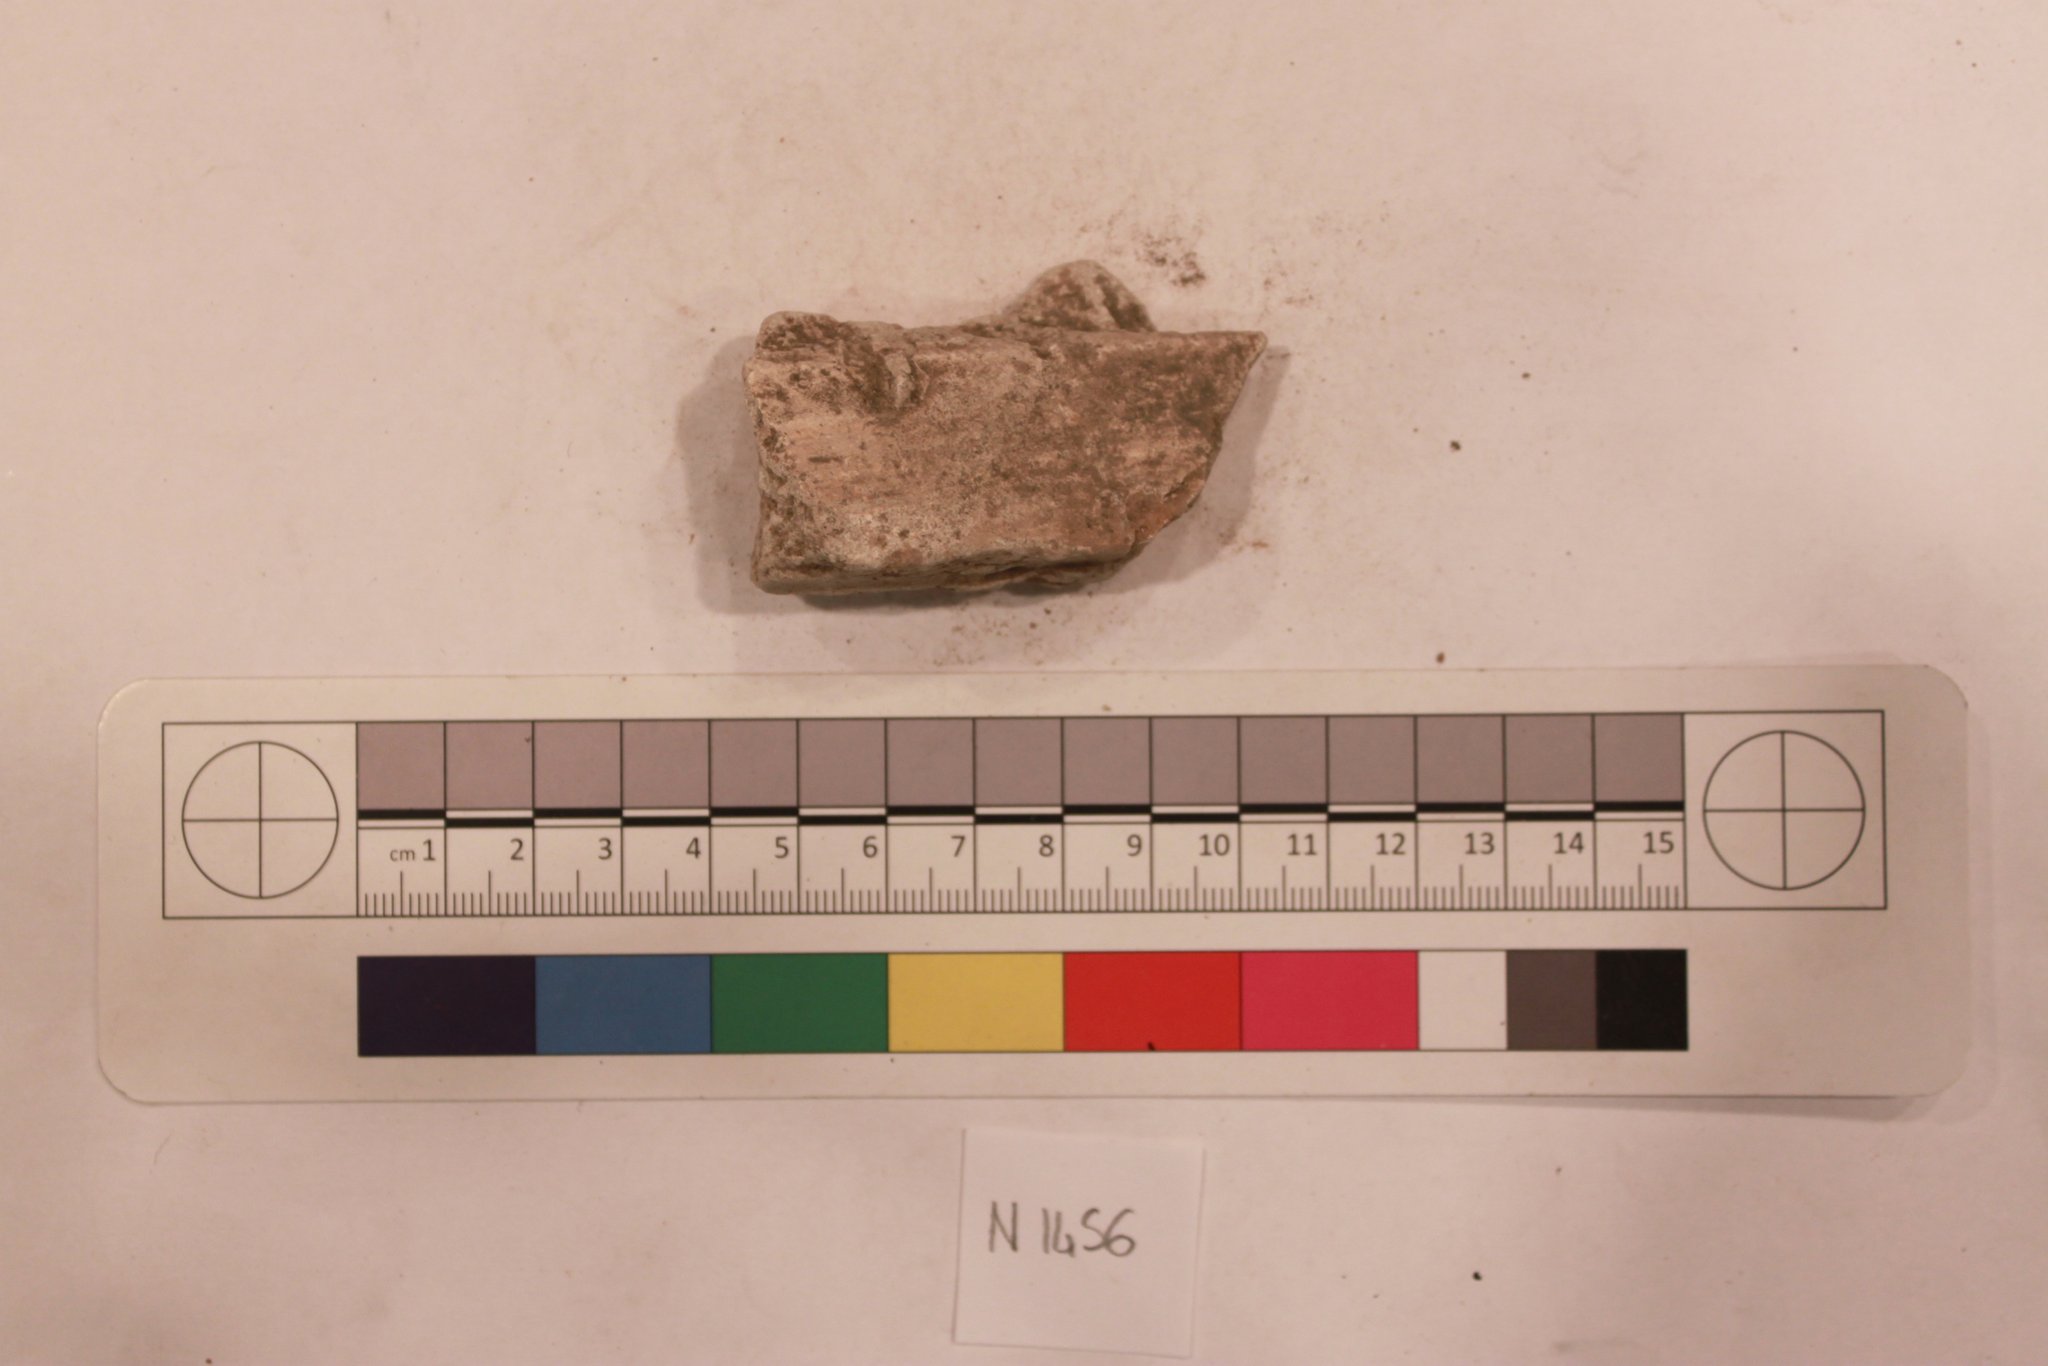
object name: fragment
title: Stucco Fragment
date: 701-1200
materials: plaster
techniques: carving, painting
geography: iran